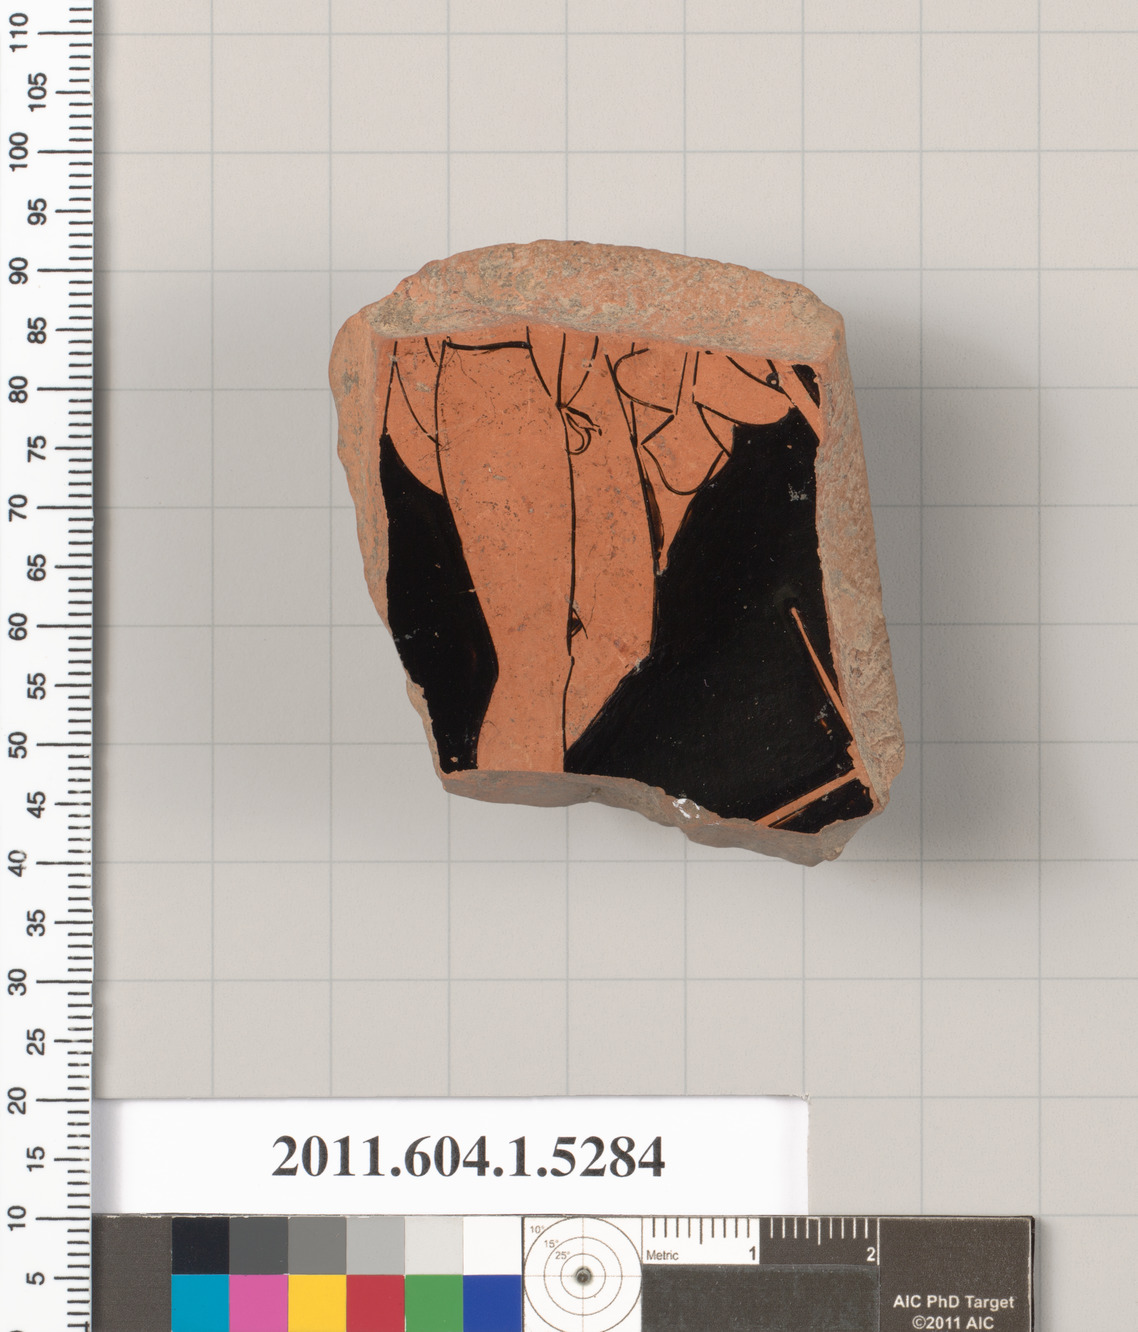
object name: kylix fragment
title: Terracotta fragment of a kylix (drinking cup)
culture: greek, attic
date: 490-480 BCE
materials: terracotta